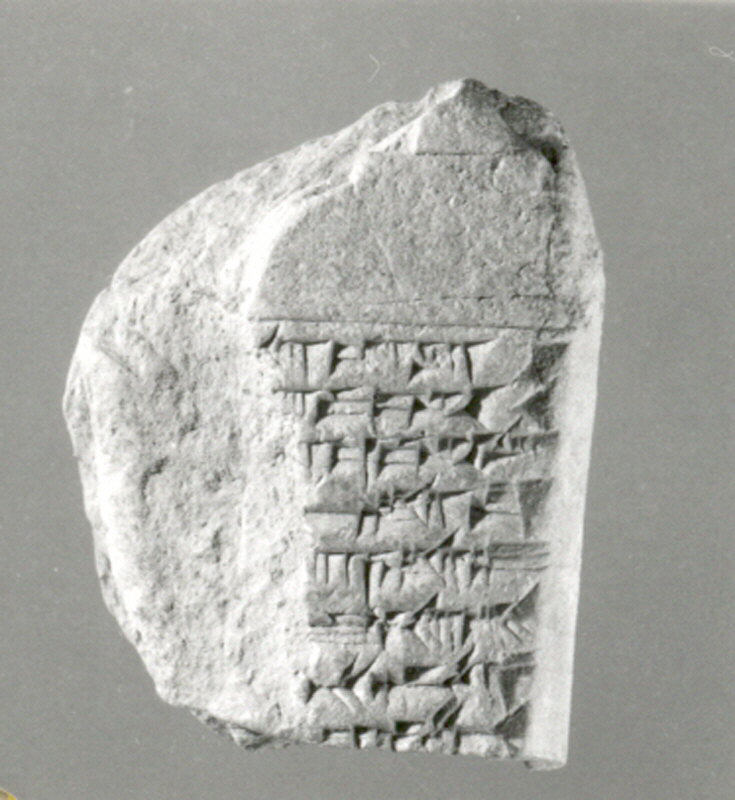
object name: cuneiform tablet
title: Cuneiform tablet: sale of real estate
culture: assyrian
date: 700-601 BCE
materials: clay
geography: mesopotamia